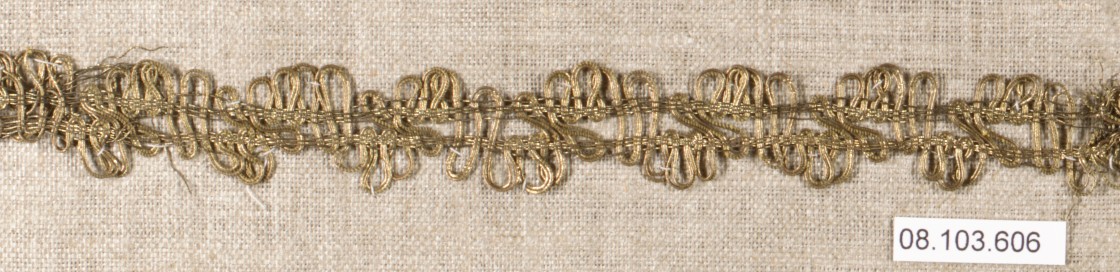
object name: galloon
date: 1701-1800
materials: metal thread